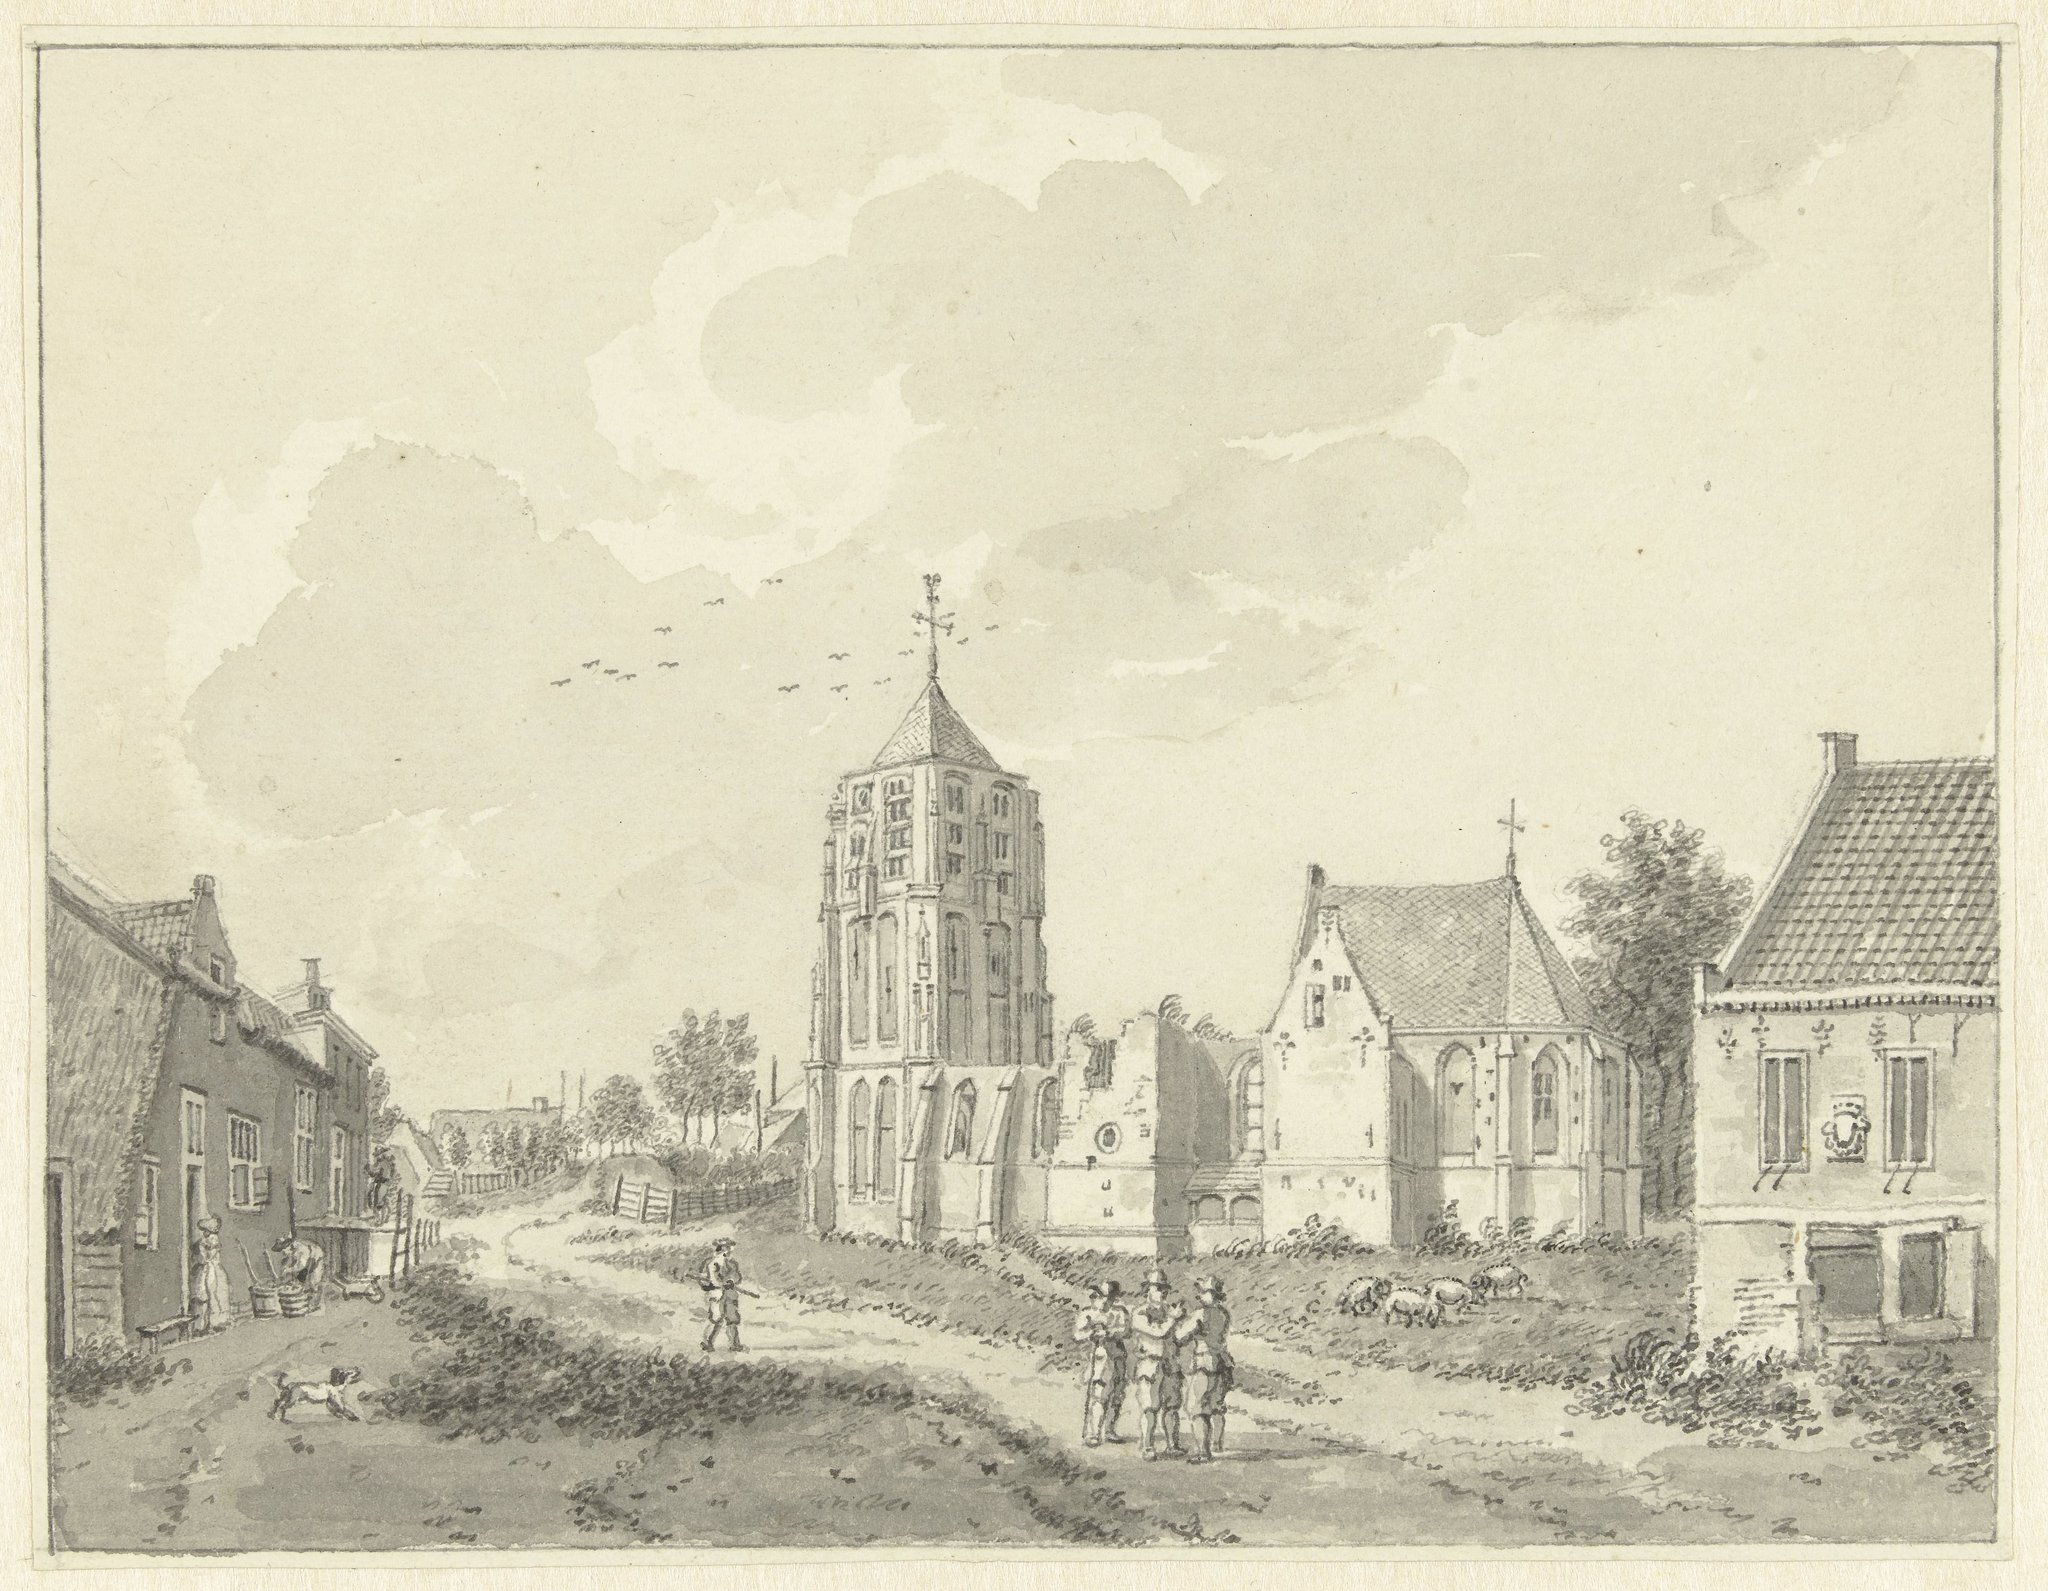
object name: drawing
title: De kerk in het dorp Acquoy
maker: hermanus petrus schouten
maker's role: draughtsman, painter, print maker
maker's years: 1747-1822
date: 1757-1822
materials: ink, paper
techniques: brush, pen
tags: village, church (exterior), ruin of church, monastery, etc.